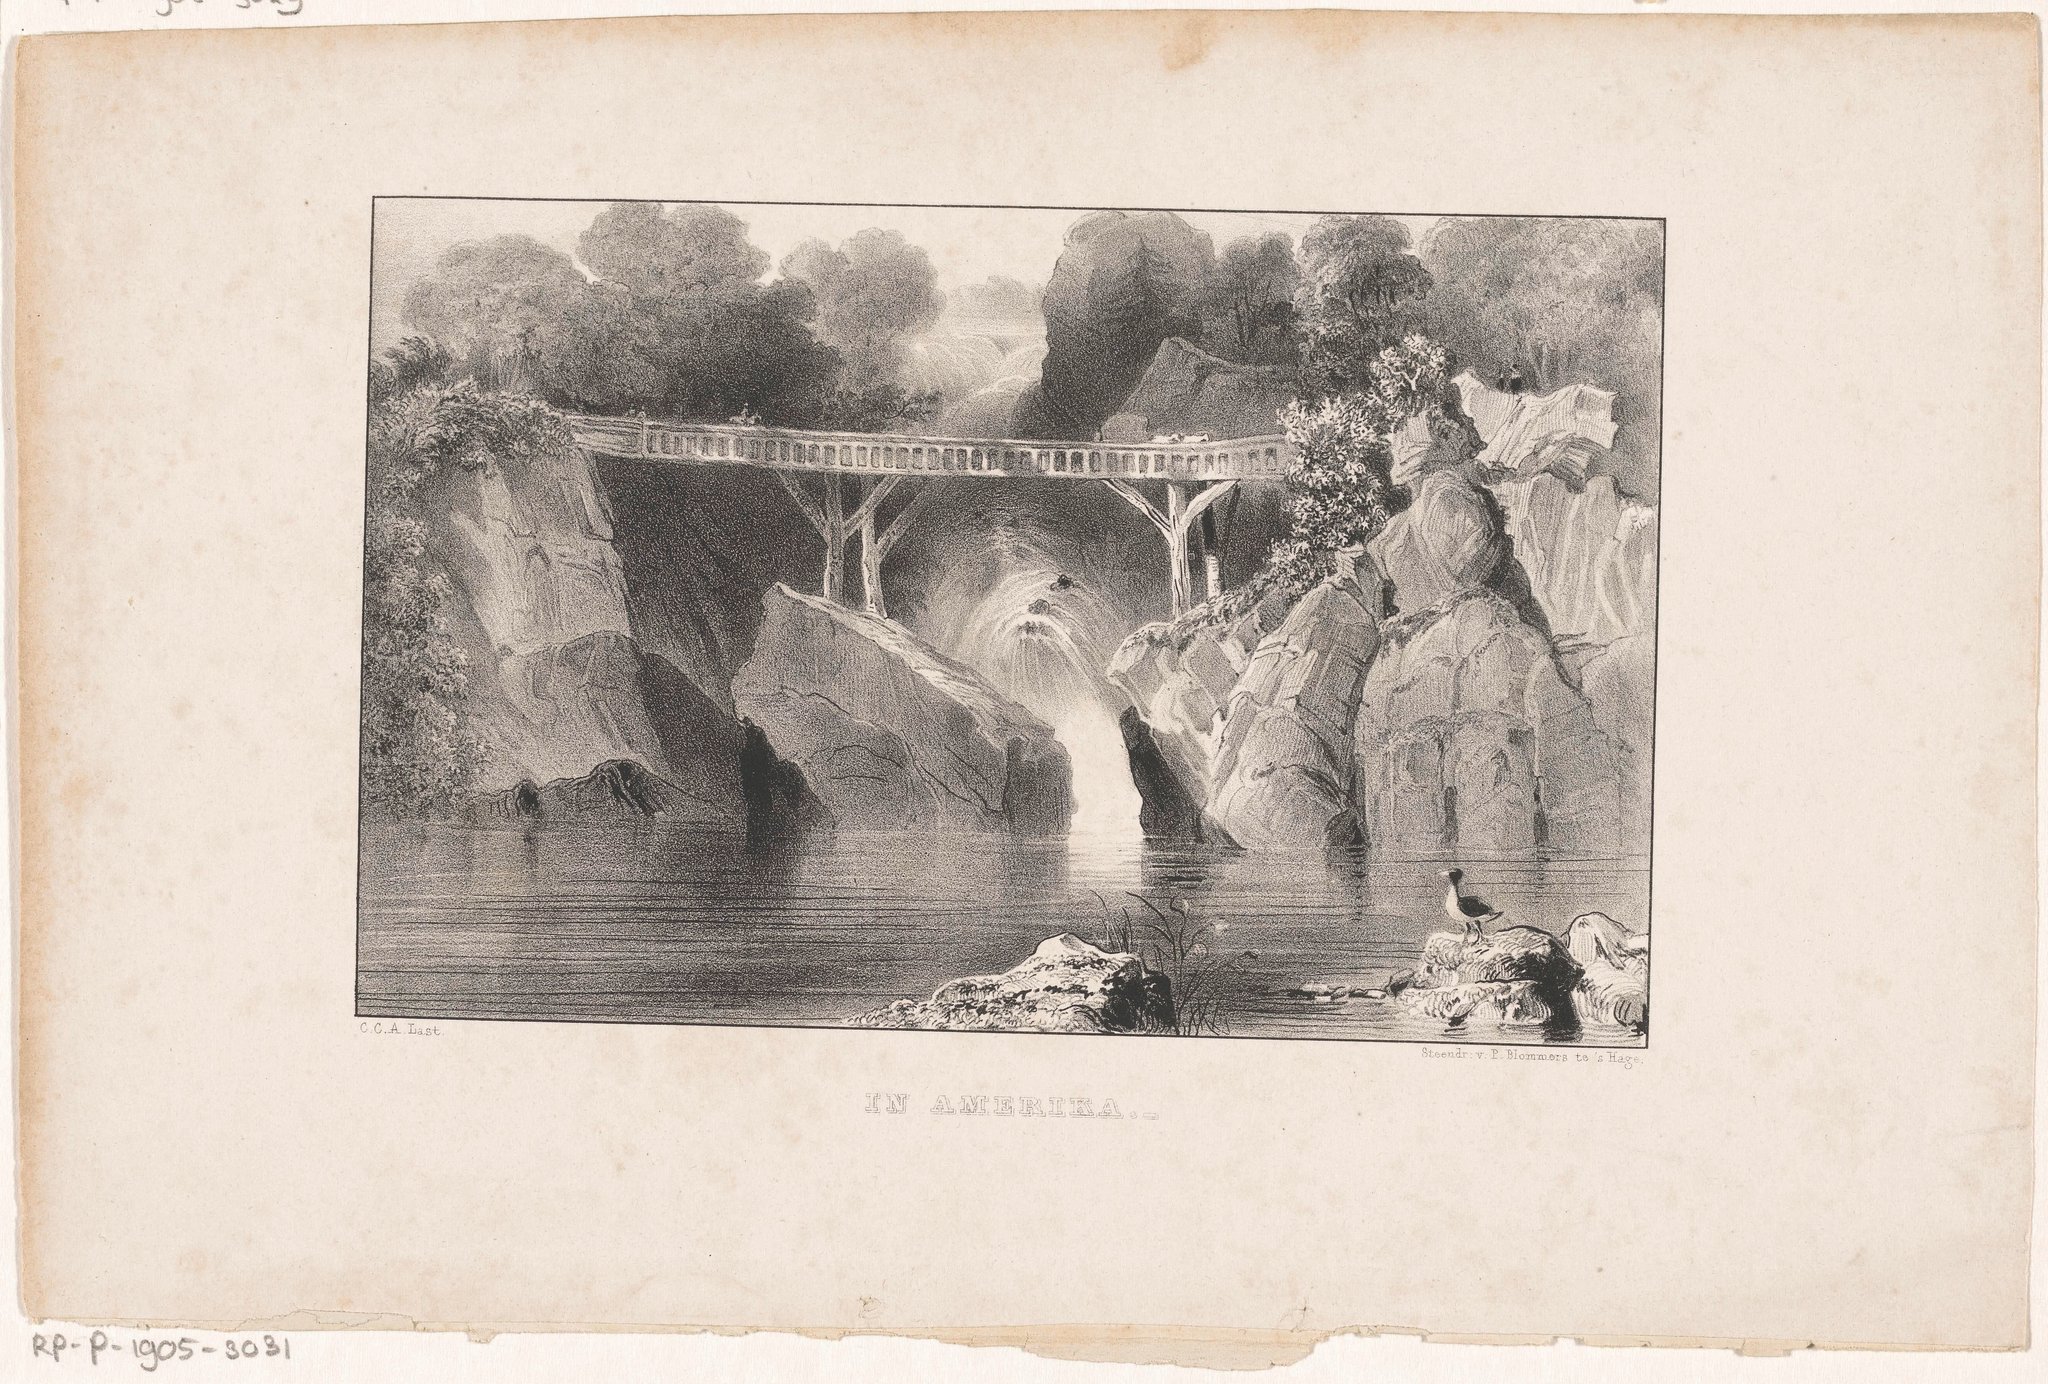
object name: print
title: Bergachtig landschap met waterval en brug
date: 1842-1887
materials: paper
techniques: lithograph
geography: the hague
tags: landscape with bridge, viaduct or aqueduct, waterfall (+ landscape with figures, staffage)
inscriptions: collector's mark: Lugt 2228